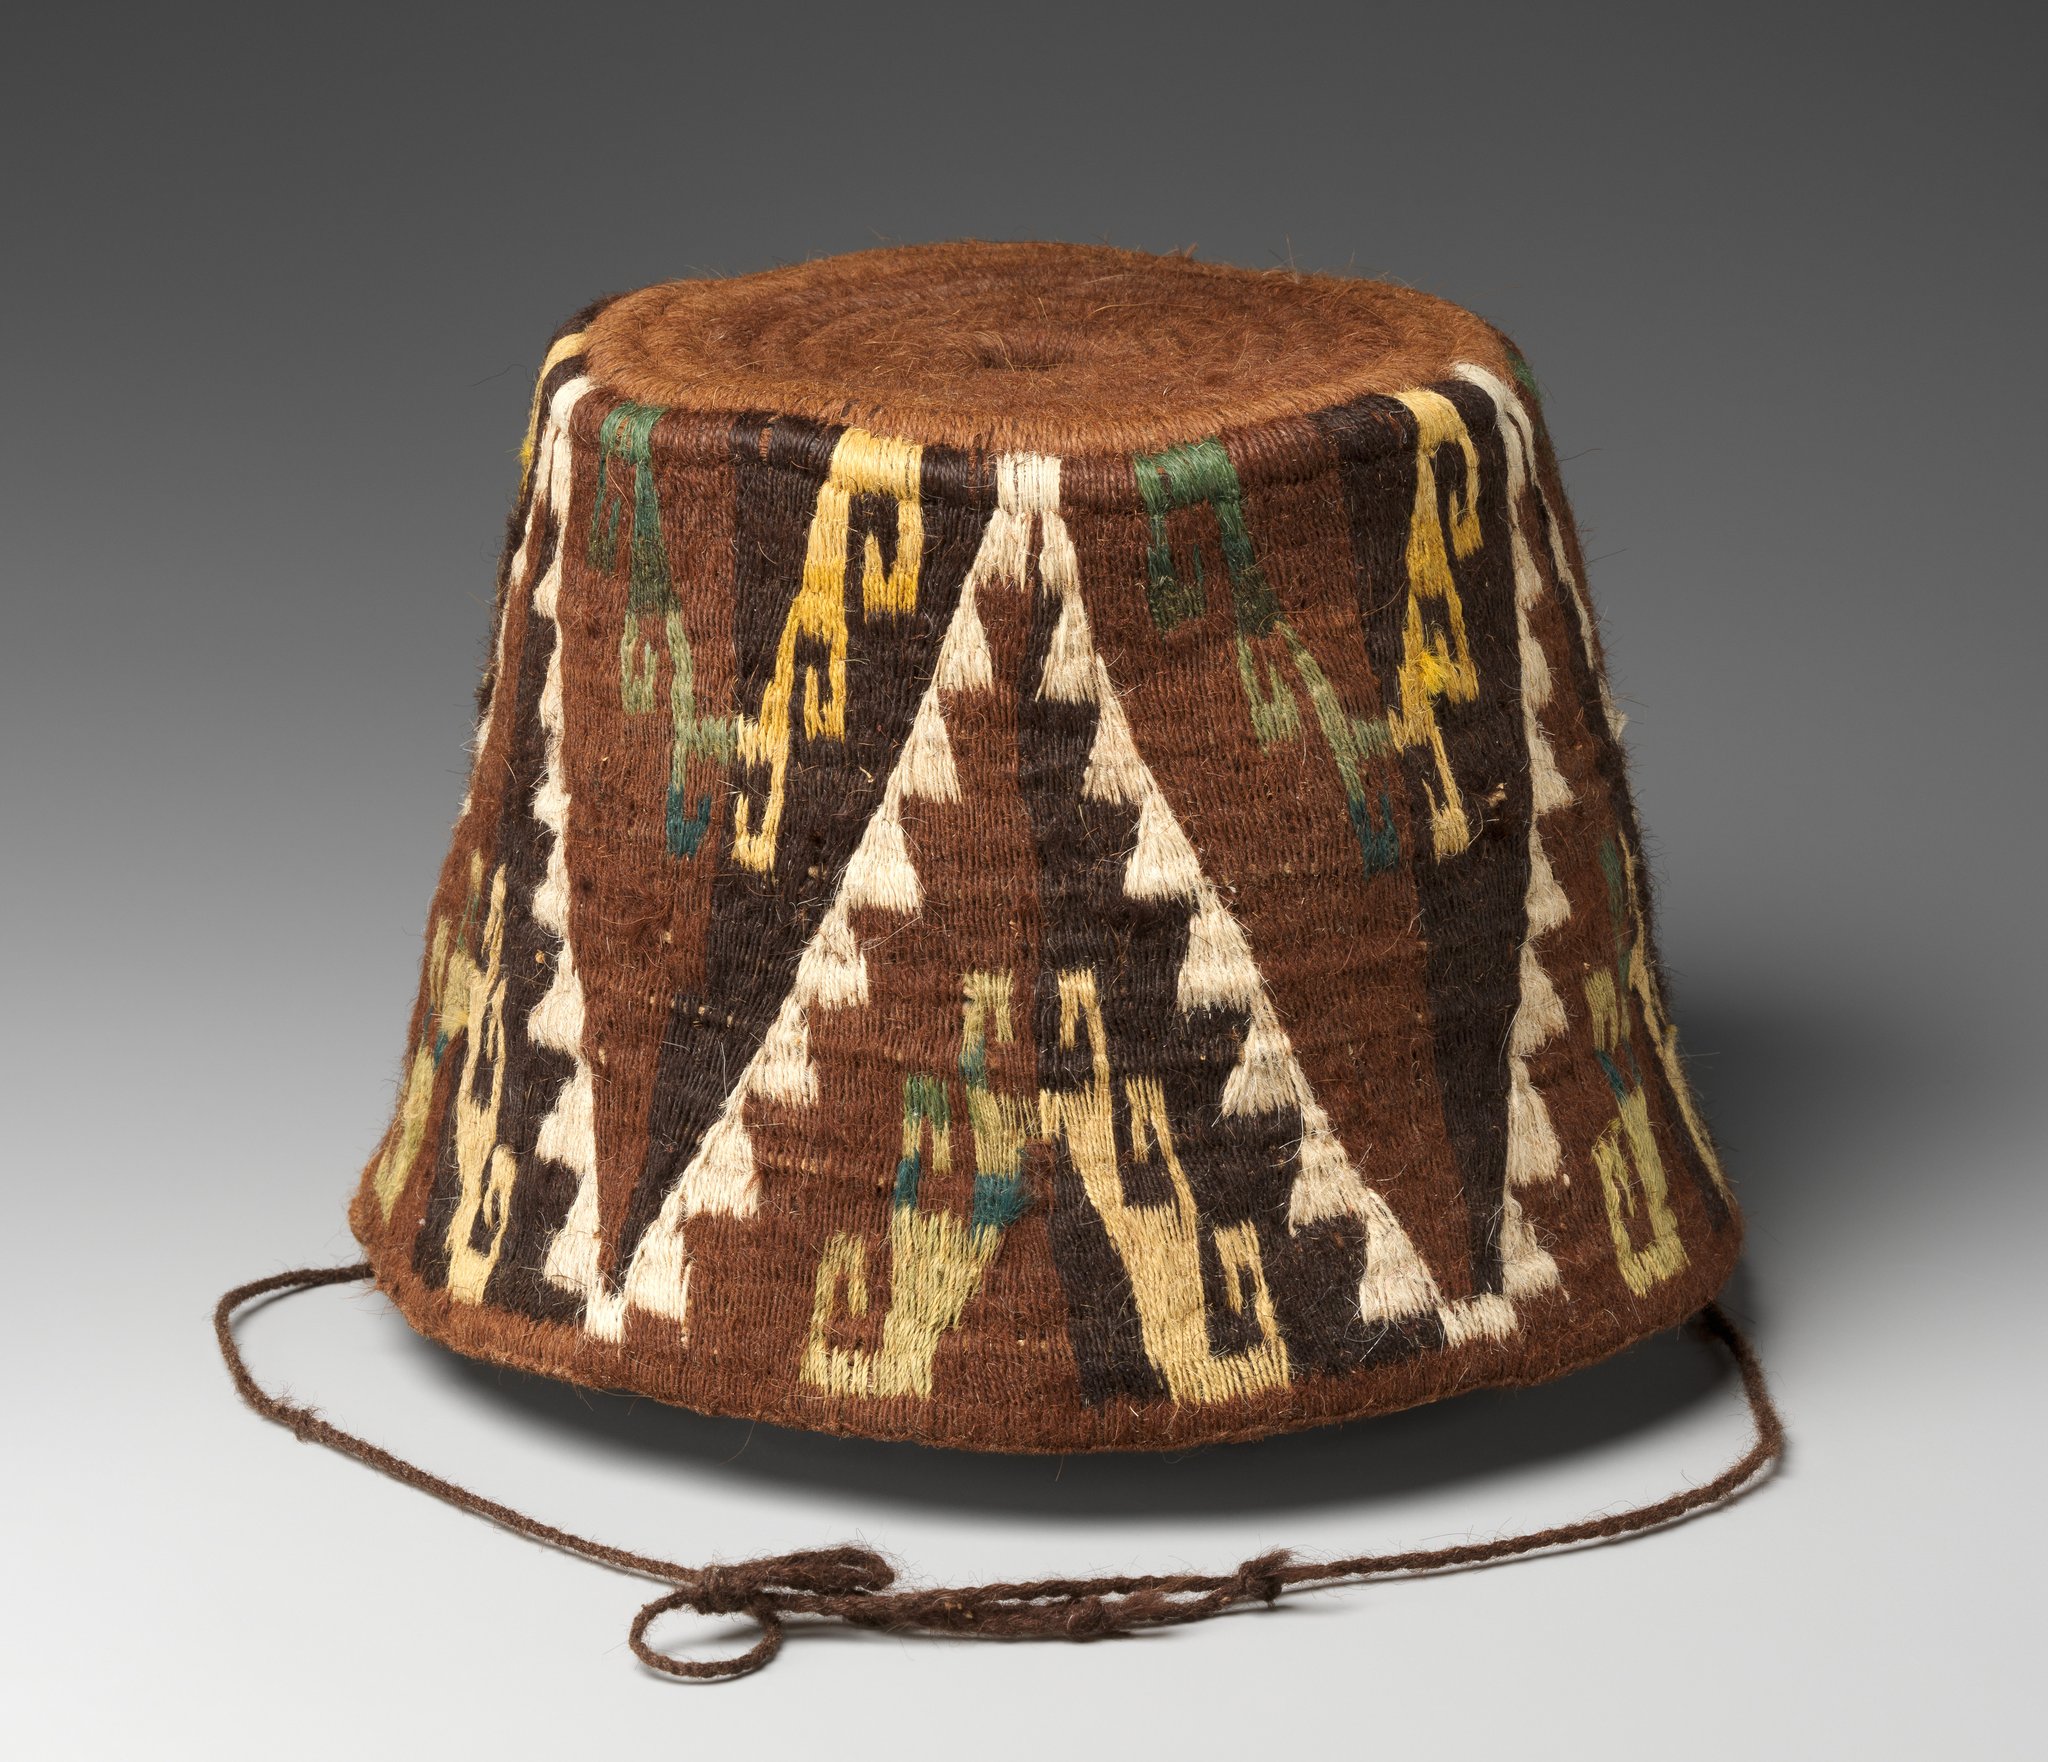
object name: hat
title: Cap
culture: arica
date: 901-1400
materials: animal fiber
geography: chile